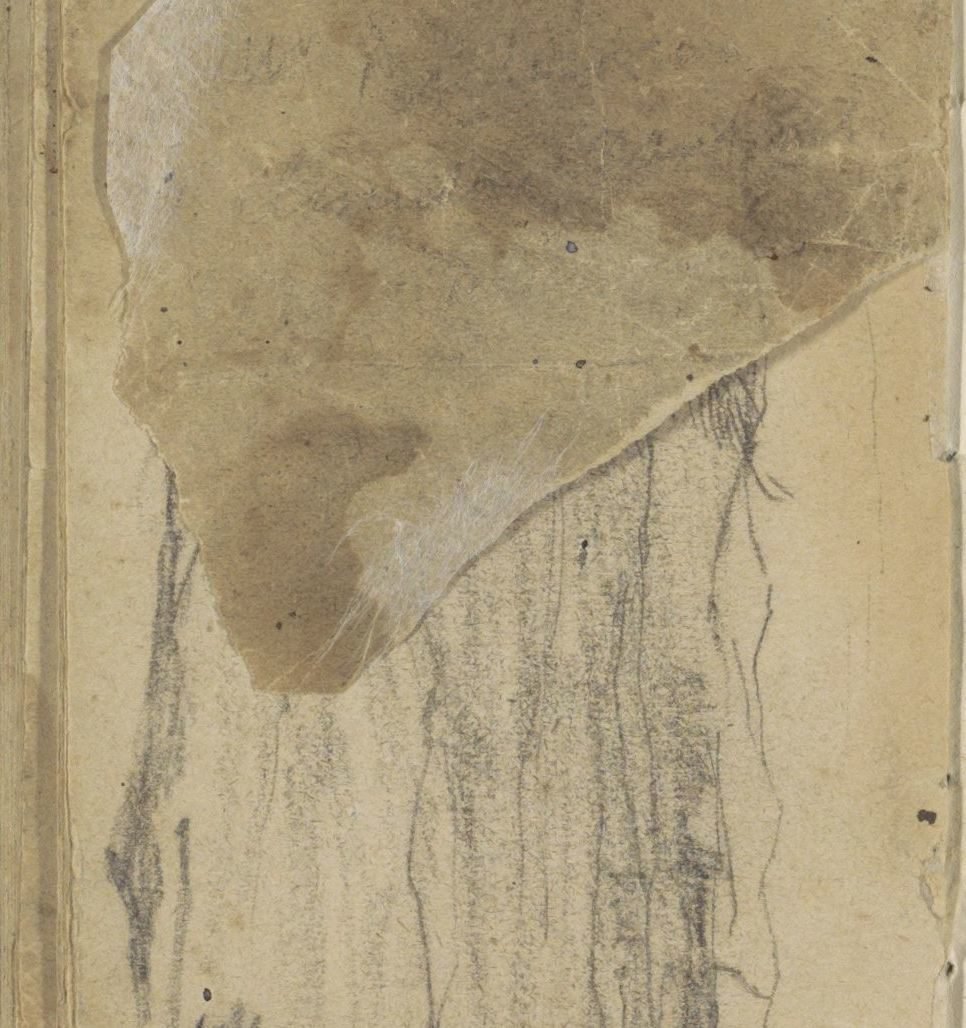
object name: sketchbook leaf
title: Annotaties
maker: george hendrik breitner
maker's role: draughtsman, painter, print maker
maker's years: 1857-1923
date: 1881-1883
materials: chalk, paper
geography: south holland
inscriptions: annotation: ‘Mr [...]’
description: Annotaties. Pagina 86 uit een schetsboek met 43 bladen.